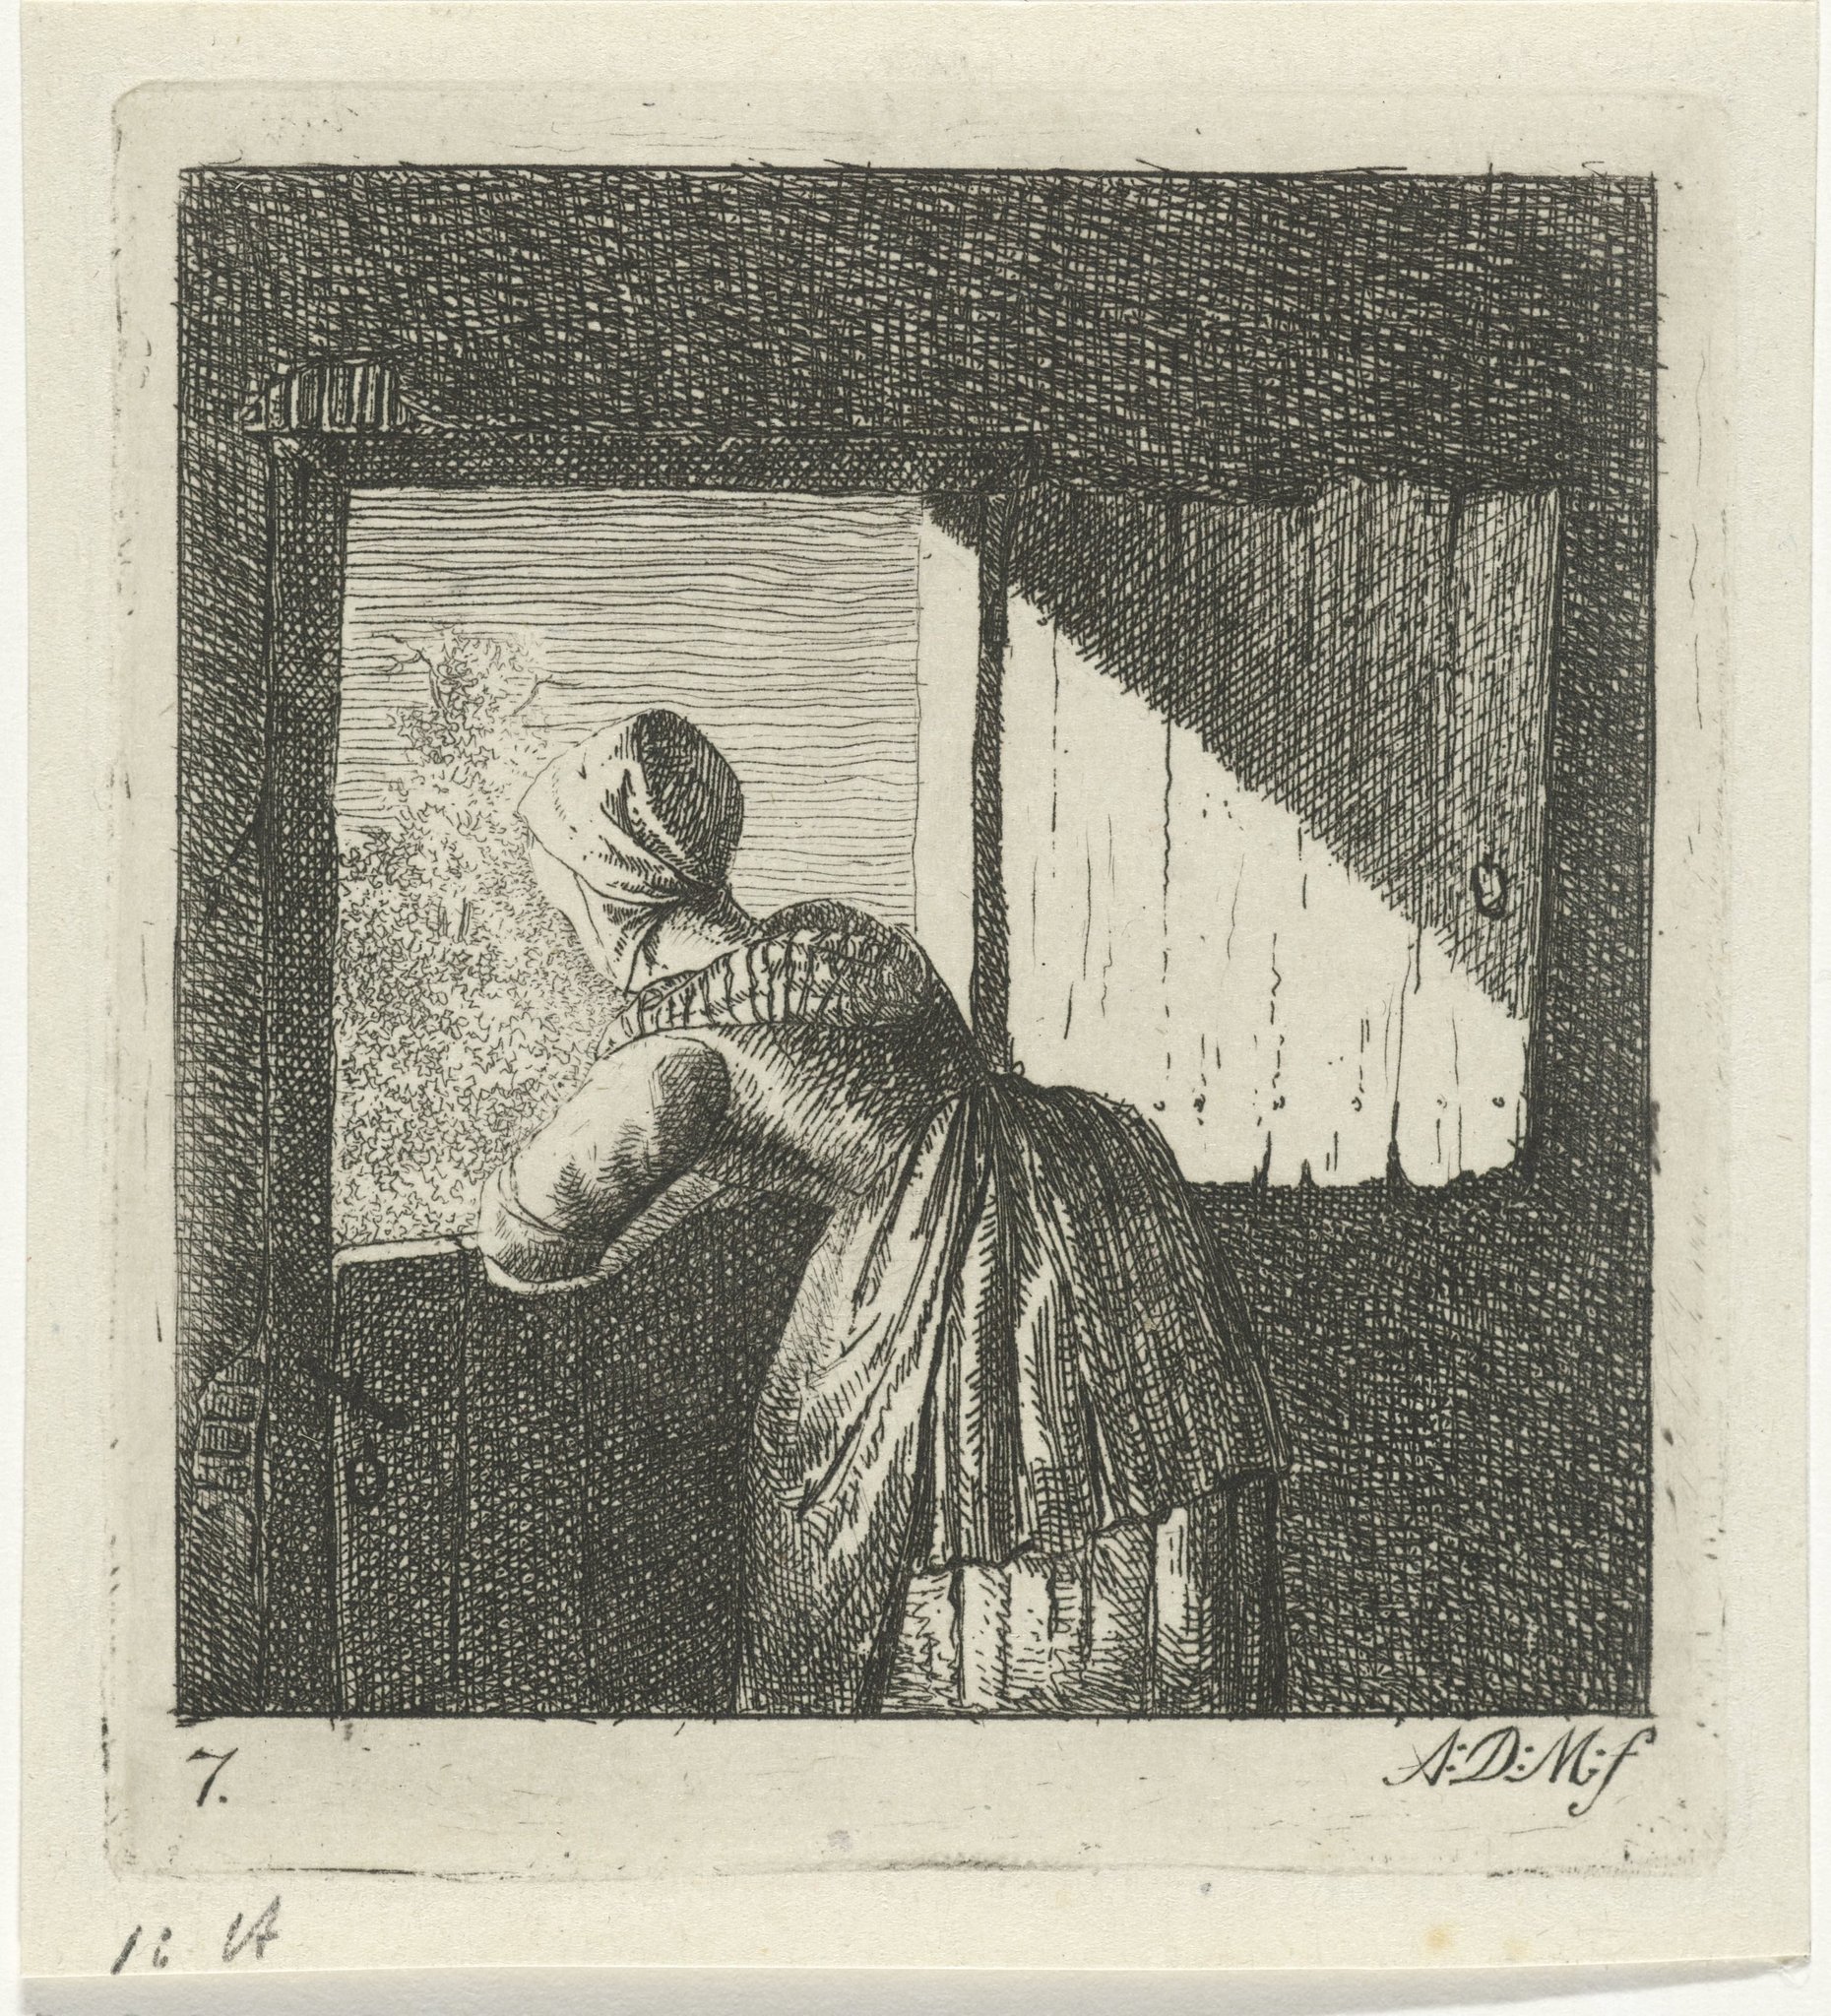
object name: print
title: Vrouw leunend op een onderdeur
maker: anthonie willem hendrik nolthenius de man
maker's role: draughtsman, print maker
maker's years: 1793-1842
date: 1803-1842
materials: paper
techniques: etching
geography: the hague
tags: adolescent, young woman, maiden, divided door, upper part opened, leaning figure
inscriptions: collector's mark: Lugt 2228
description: Een vrouw, op de rug gezien, leunend op een onderdeur.